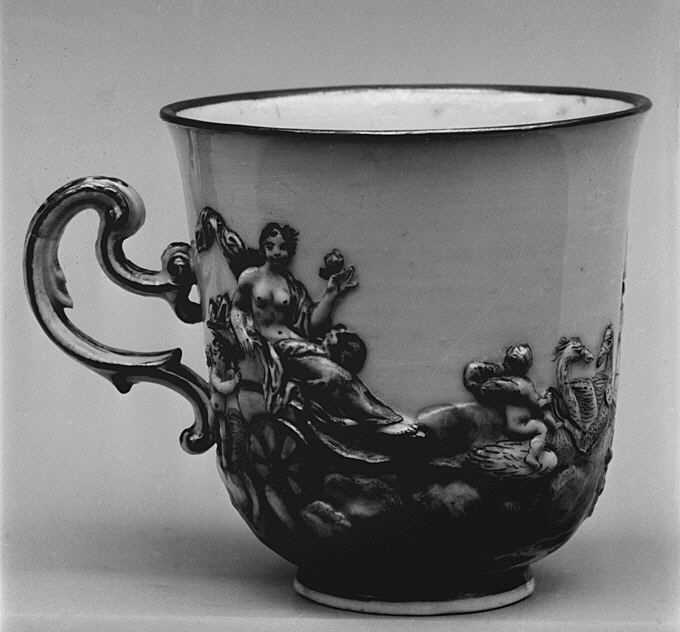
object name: coffee cup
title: Coffee cup (part of a service)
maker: doccia porcelain manufactory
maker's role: manufactory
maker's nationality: italian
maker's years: 1737-1896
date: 1760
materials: hard paste porcelain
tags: female nudes,putti,swans